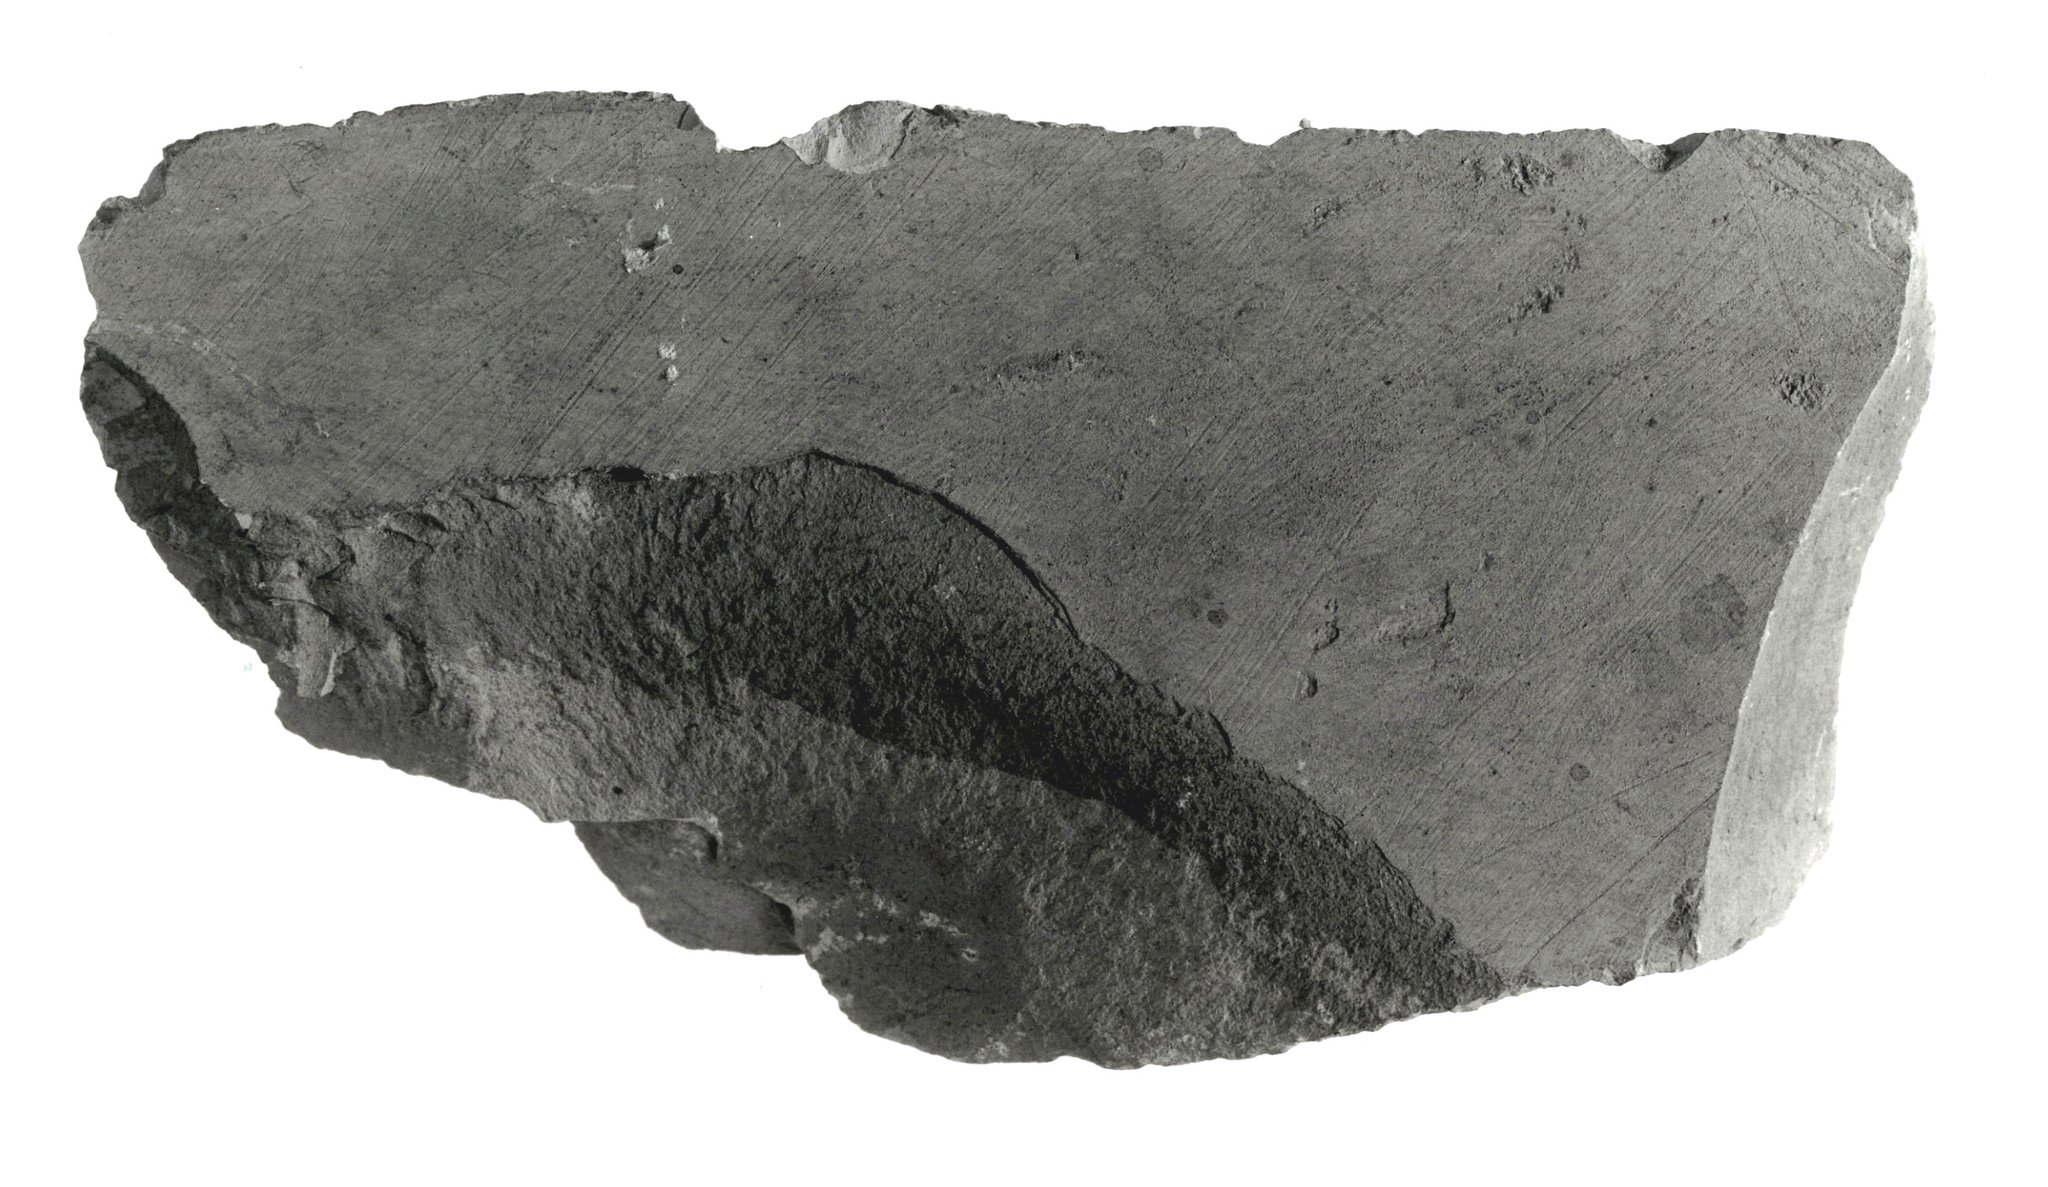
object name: relief, tomb of nespekashuty, wall casing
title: Wall casing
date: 664-610 BCE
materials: limestone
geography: egypt